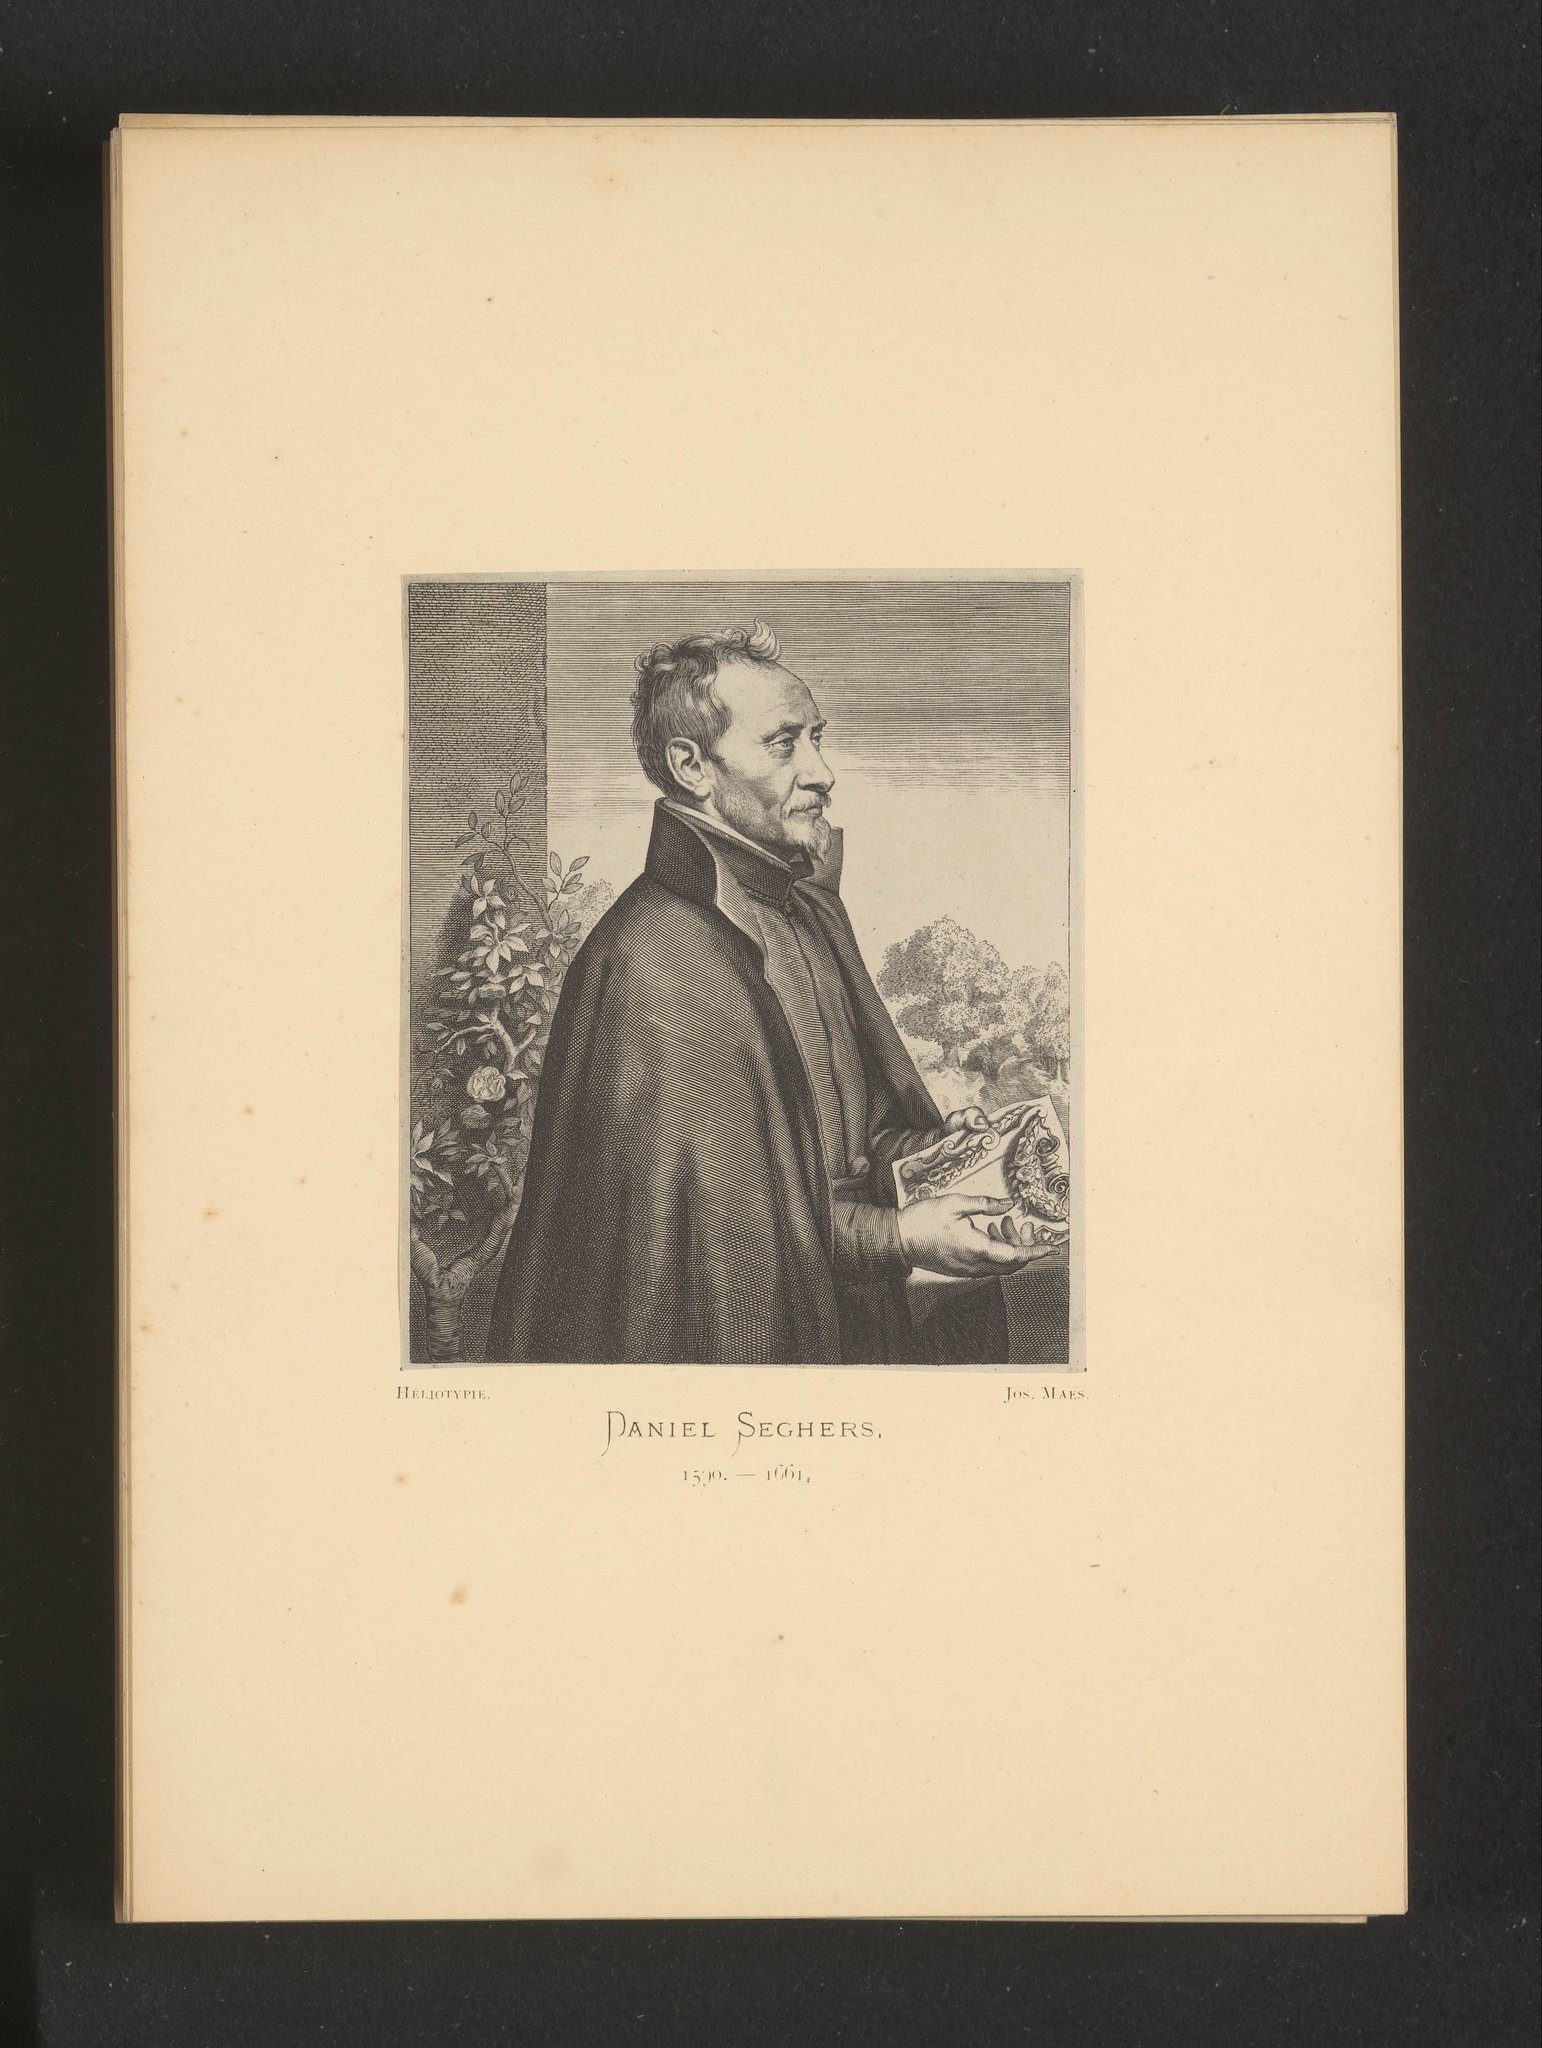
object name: photomechanical print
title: Daniel Seghers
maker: joseph maes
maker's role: fotograaf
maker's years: 1838-1908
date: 1872-1877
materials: cardboard, paper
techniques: photograph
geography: antwerp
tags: antwerp, painter, historical persons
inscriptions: inscription: ‘1590. - 1661.’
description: Deze prent maakt deel uit van een omslag met 150 prenten en een katern met een lijst van afbeeldingen.